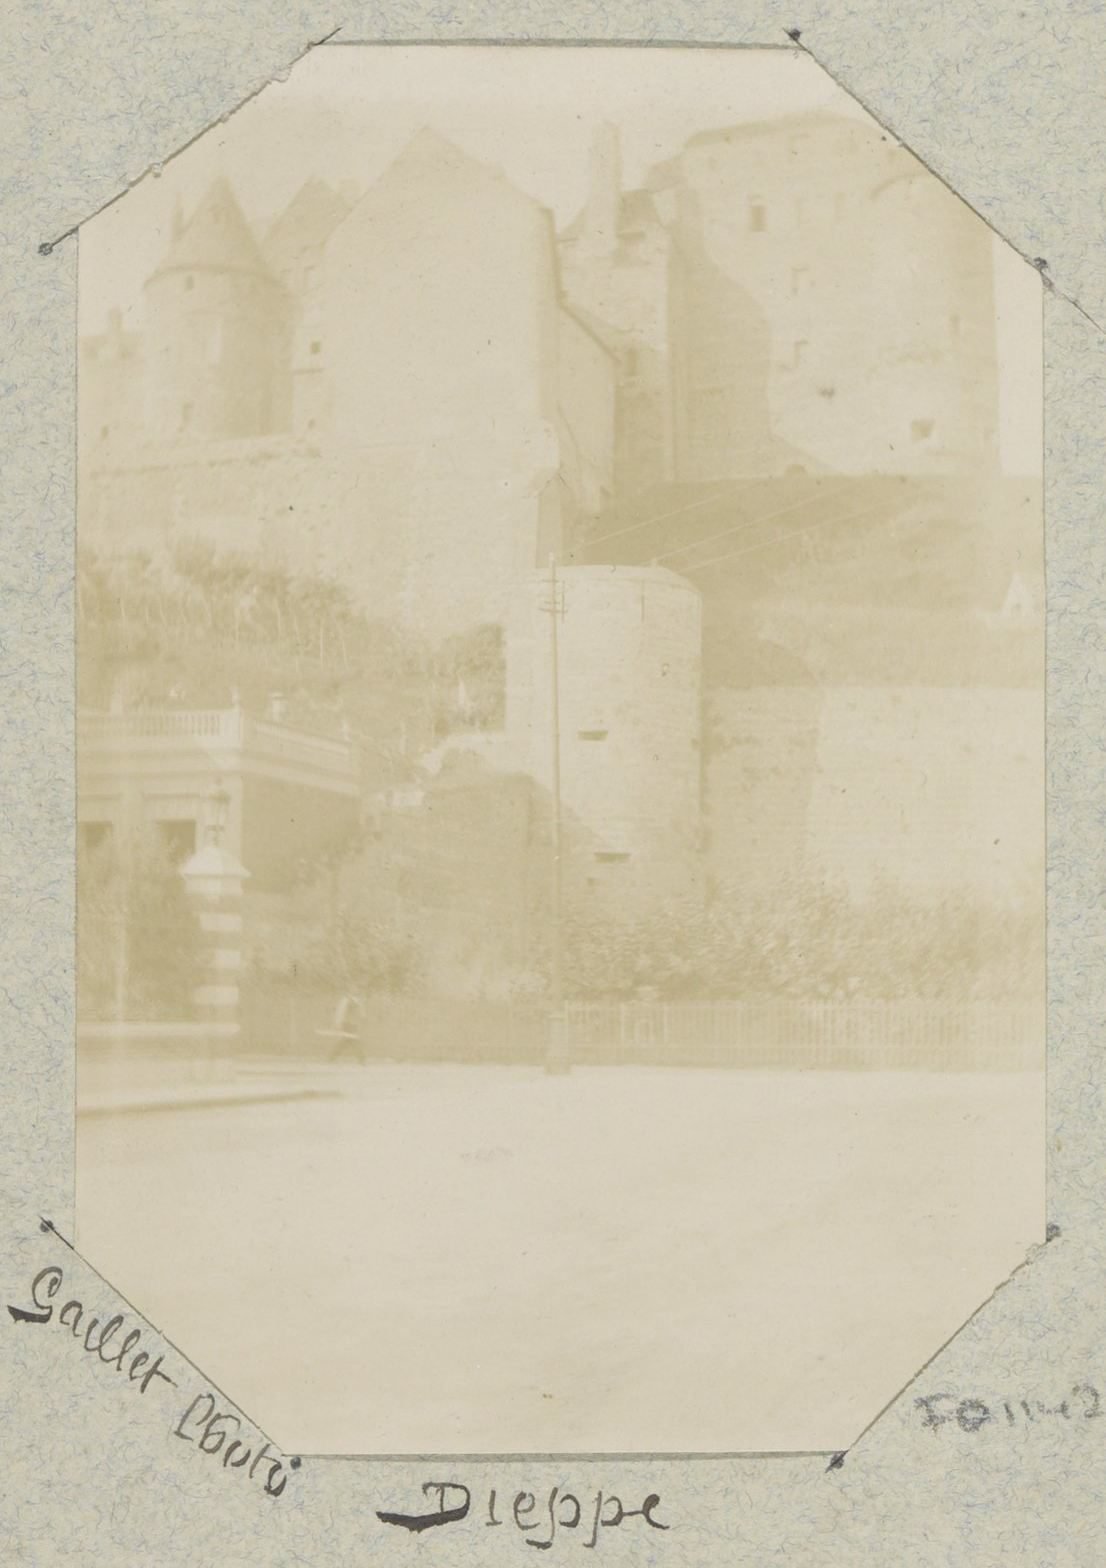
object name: photograph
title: Exterieur van het Kasteel van Dieppe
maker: gaillet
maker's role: amateurfotograaf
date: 1890-1900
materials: paper, photographic support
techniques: daylight paper print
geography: dieppe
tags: castle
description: Onderdeel van Album van een Franse amateur met foto's van Frankrijk, Algerije, Palmyra, de Wereldtentoonstelling van 1900 en van bekende Fransen.